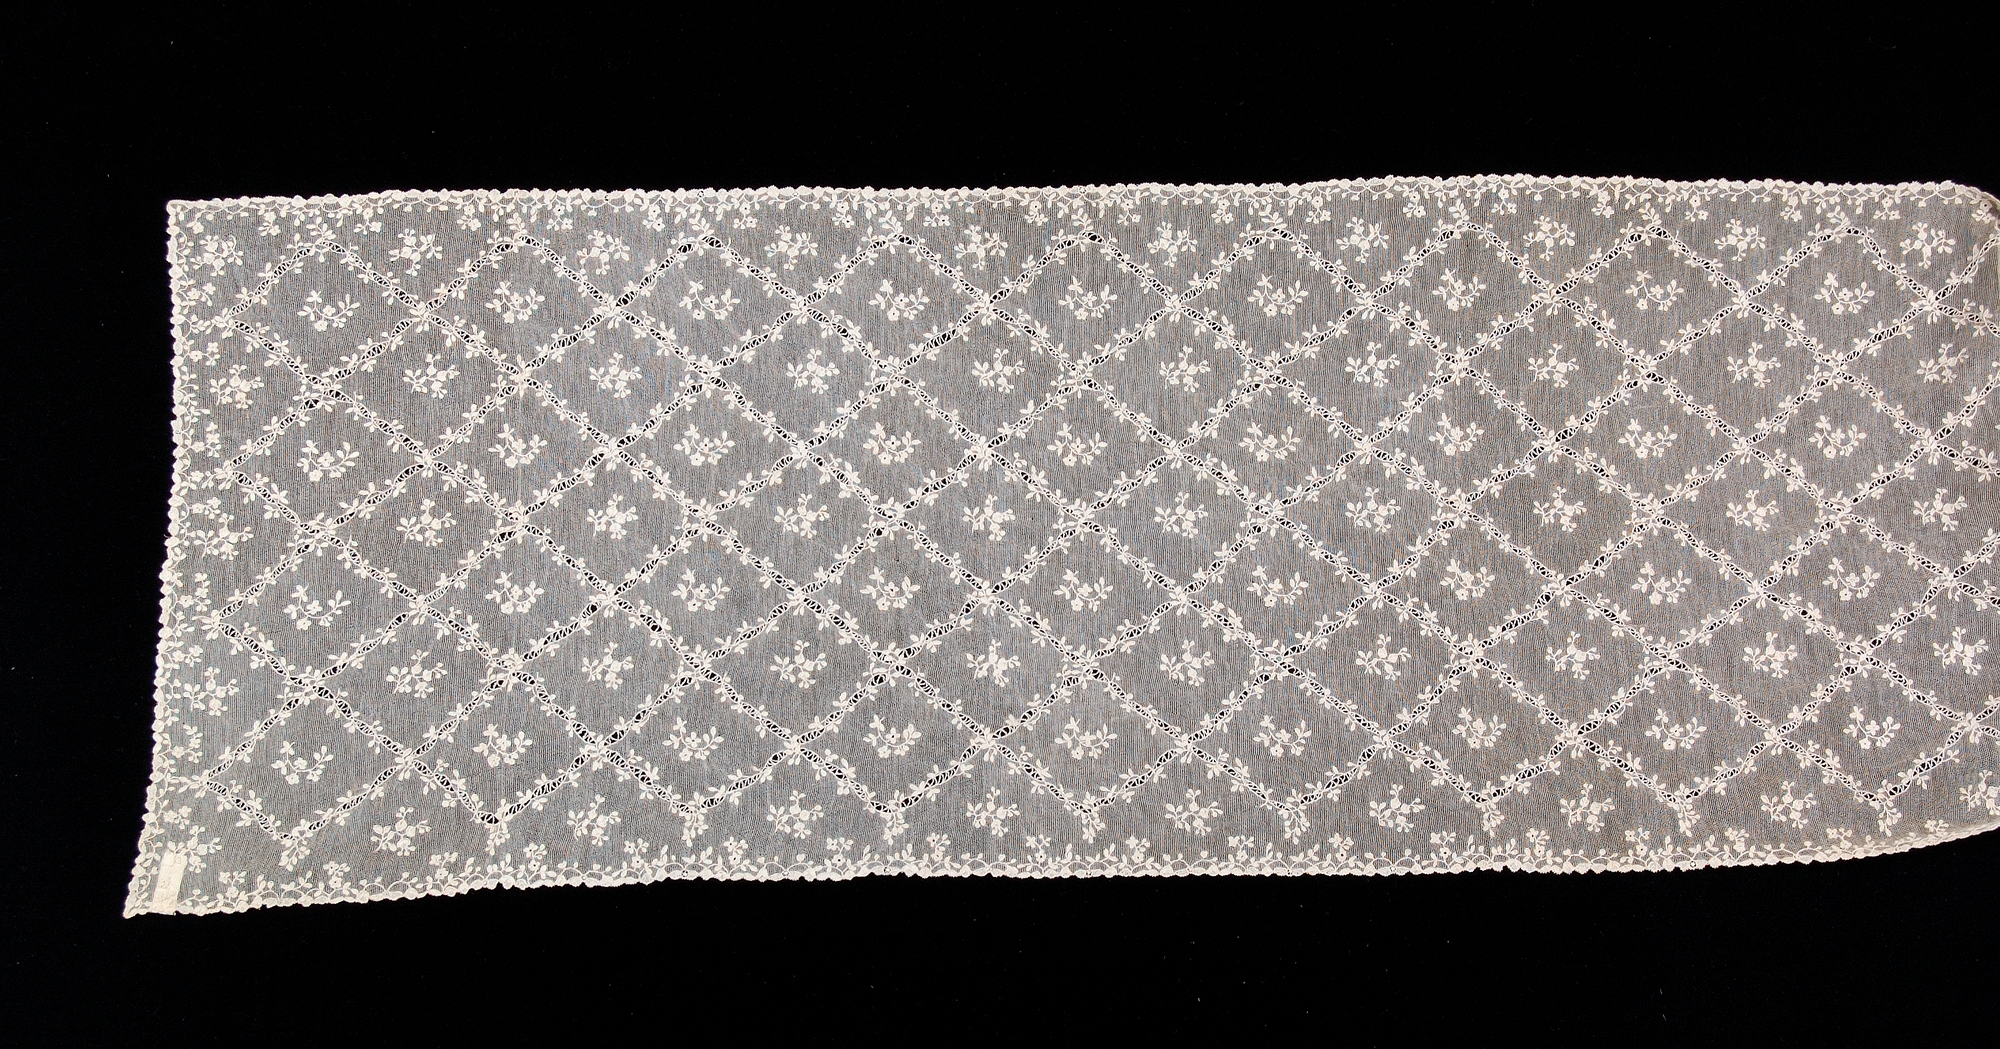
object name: stole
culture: french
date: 1776-1800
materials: linen